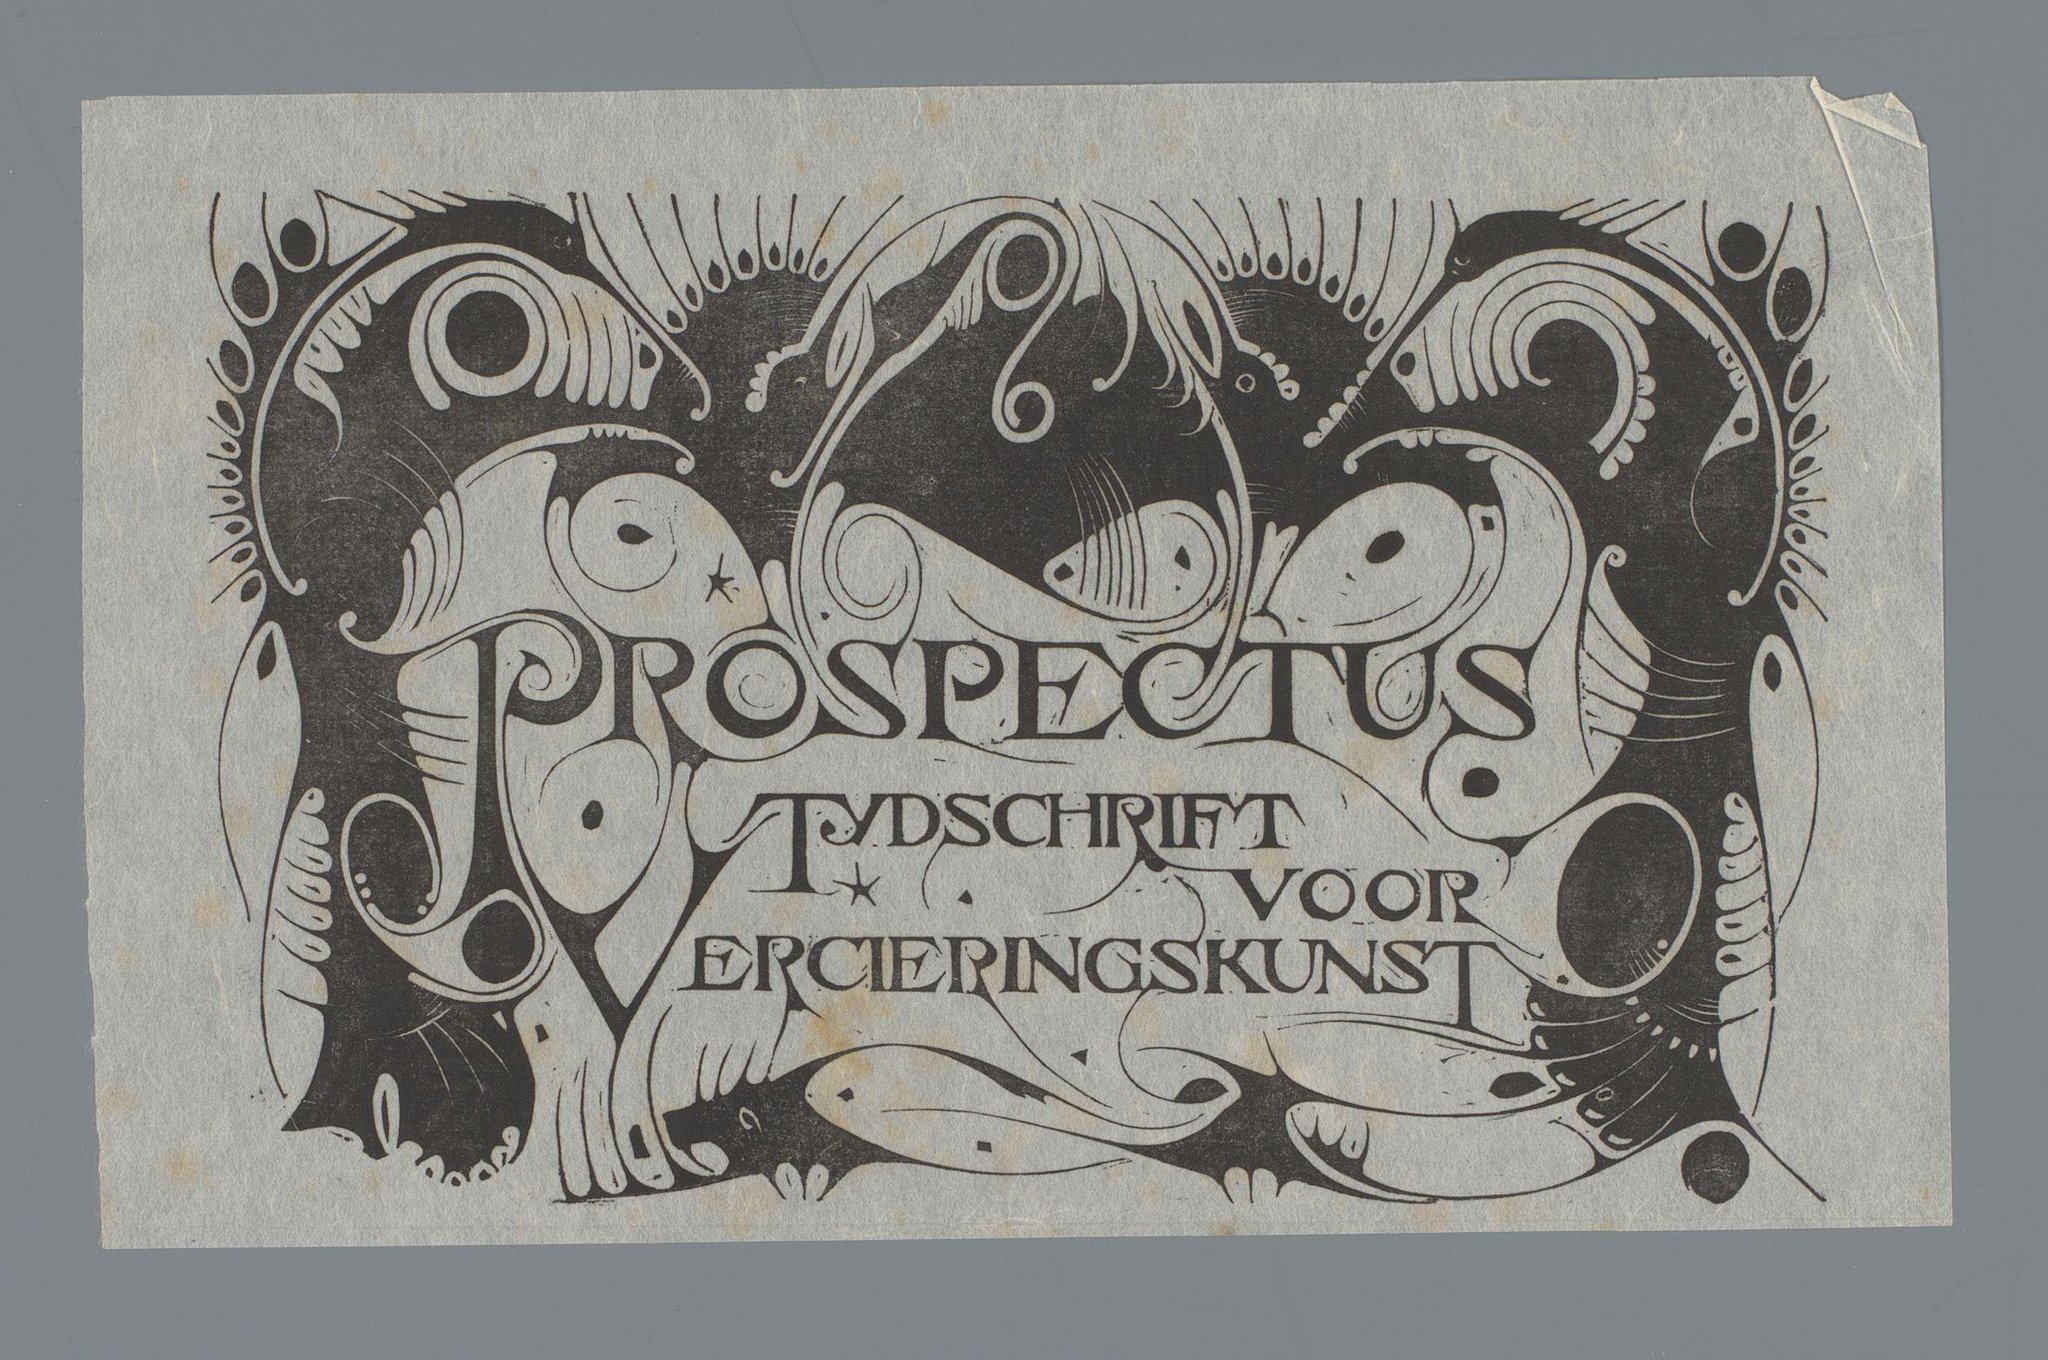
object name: print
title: Prospectus tydschrift voor vercieringskunst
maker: karel petrus cornelis de bazel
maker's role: draughtsman, print maker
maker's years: 1869-1923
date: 1896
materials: paper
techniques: woodcut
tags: title-page, ornament derived from plant forms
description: Fragment van: Prospectus tijdschrift voor vercieringskunst. Haarlem: H. Kleinmann & Co., 1896.